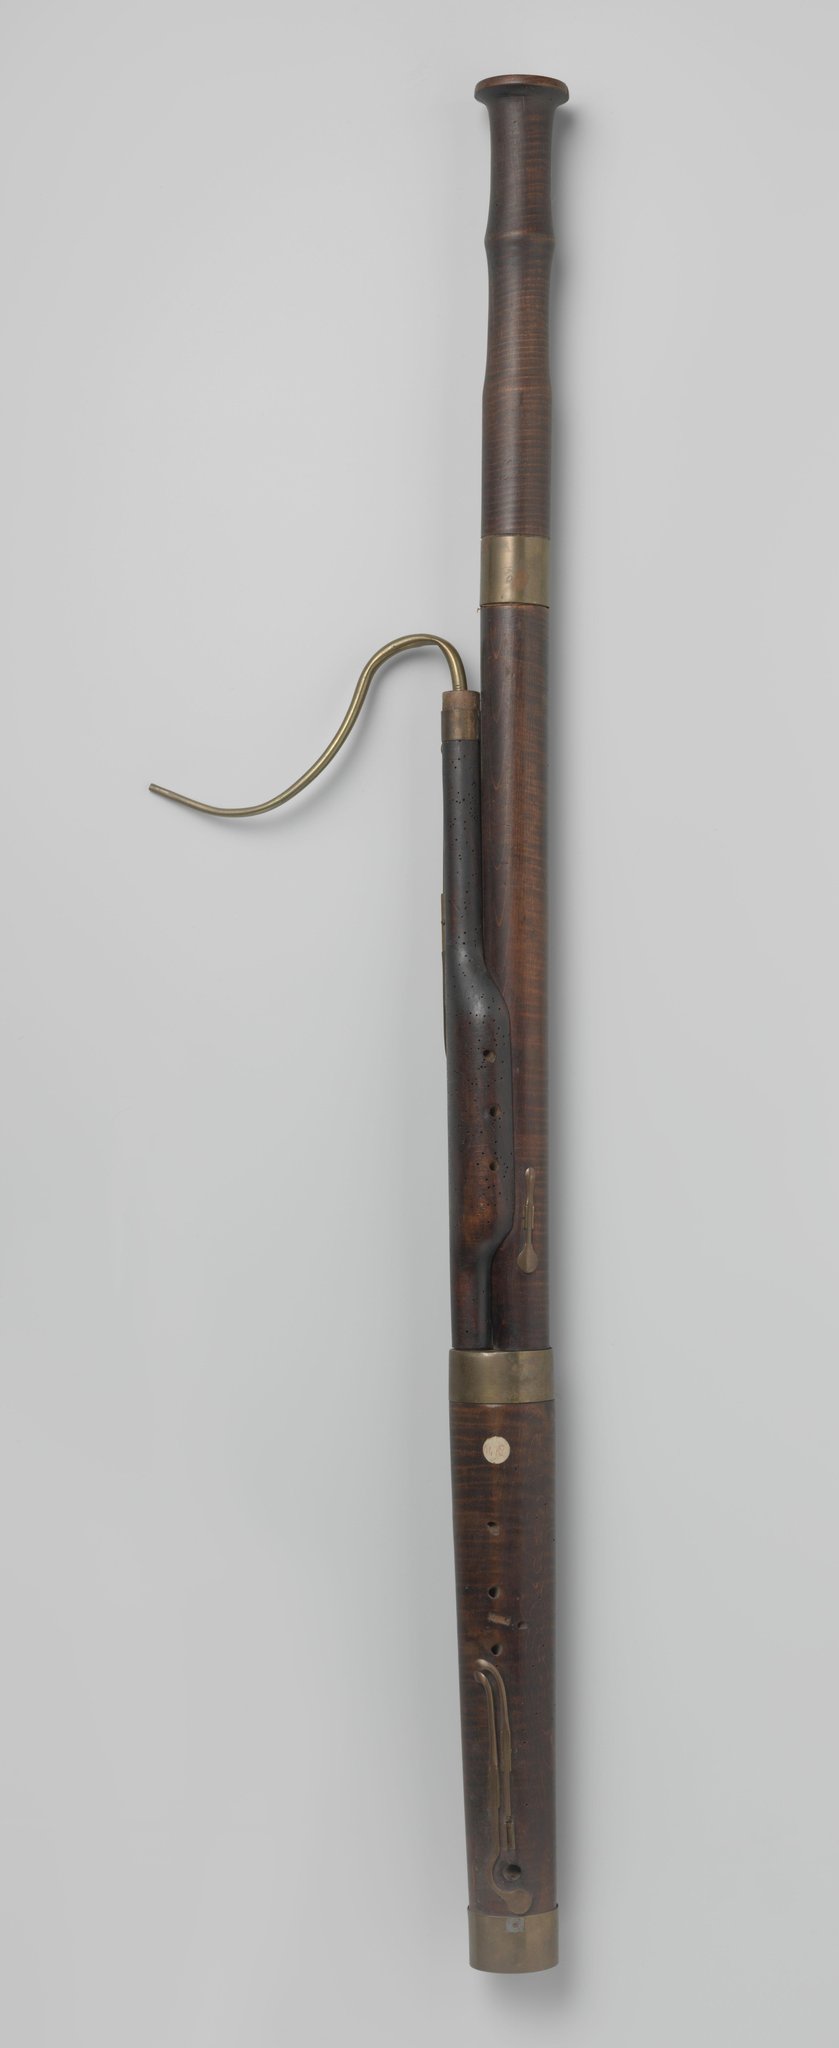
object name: wind instrument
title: Bassoon part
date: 1820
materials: copper, wood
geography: amsterdam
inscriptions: stamp: ‘L. Embach en Co t' Amsterdam’